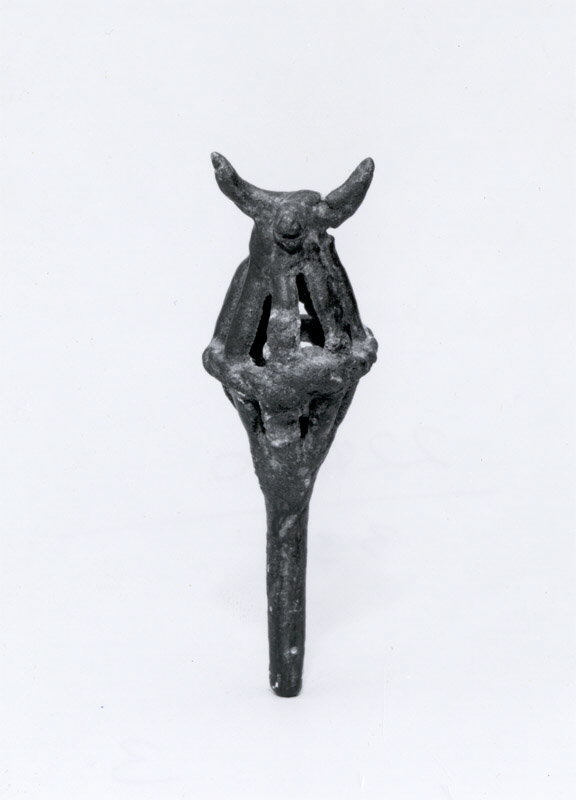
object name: rattle bell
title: Openwork rattle bell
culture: iranian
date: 900-801 BCE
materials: bronze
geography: western iran